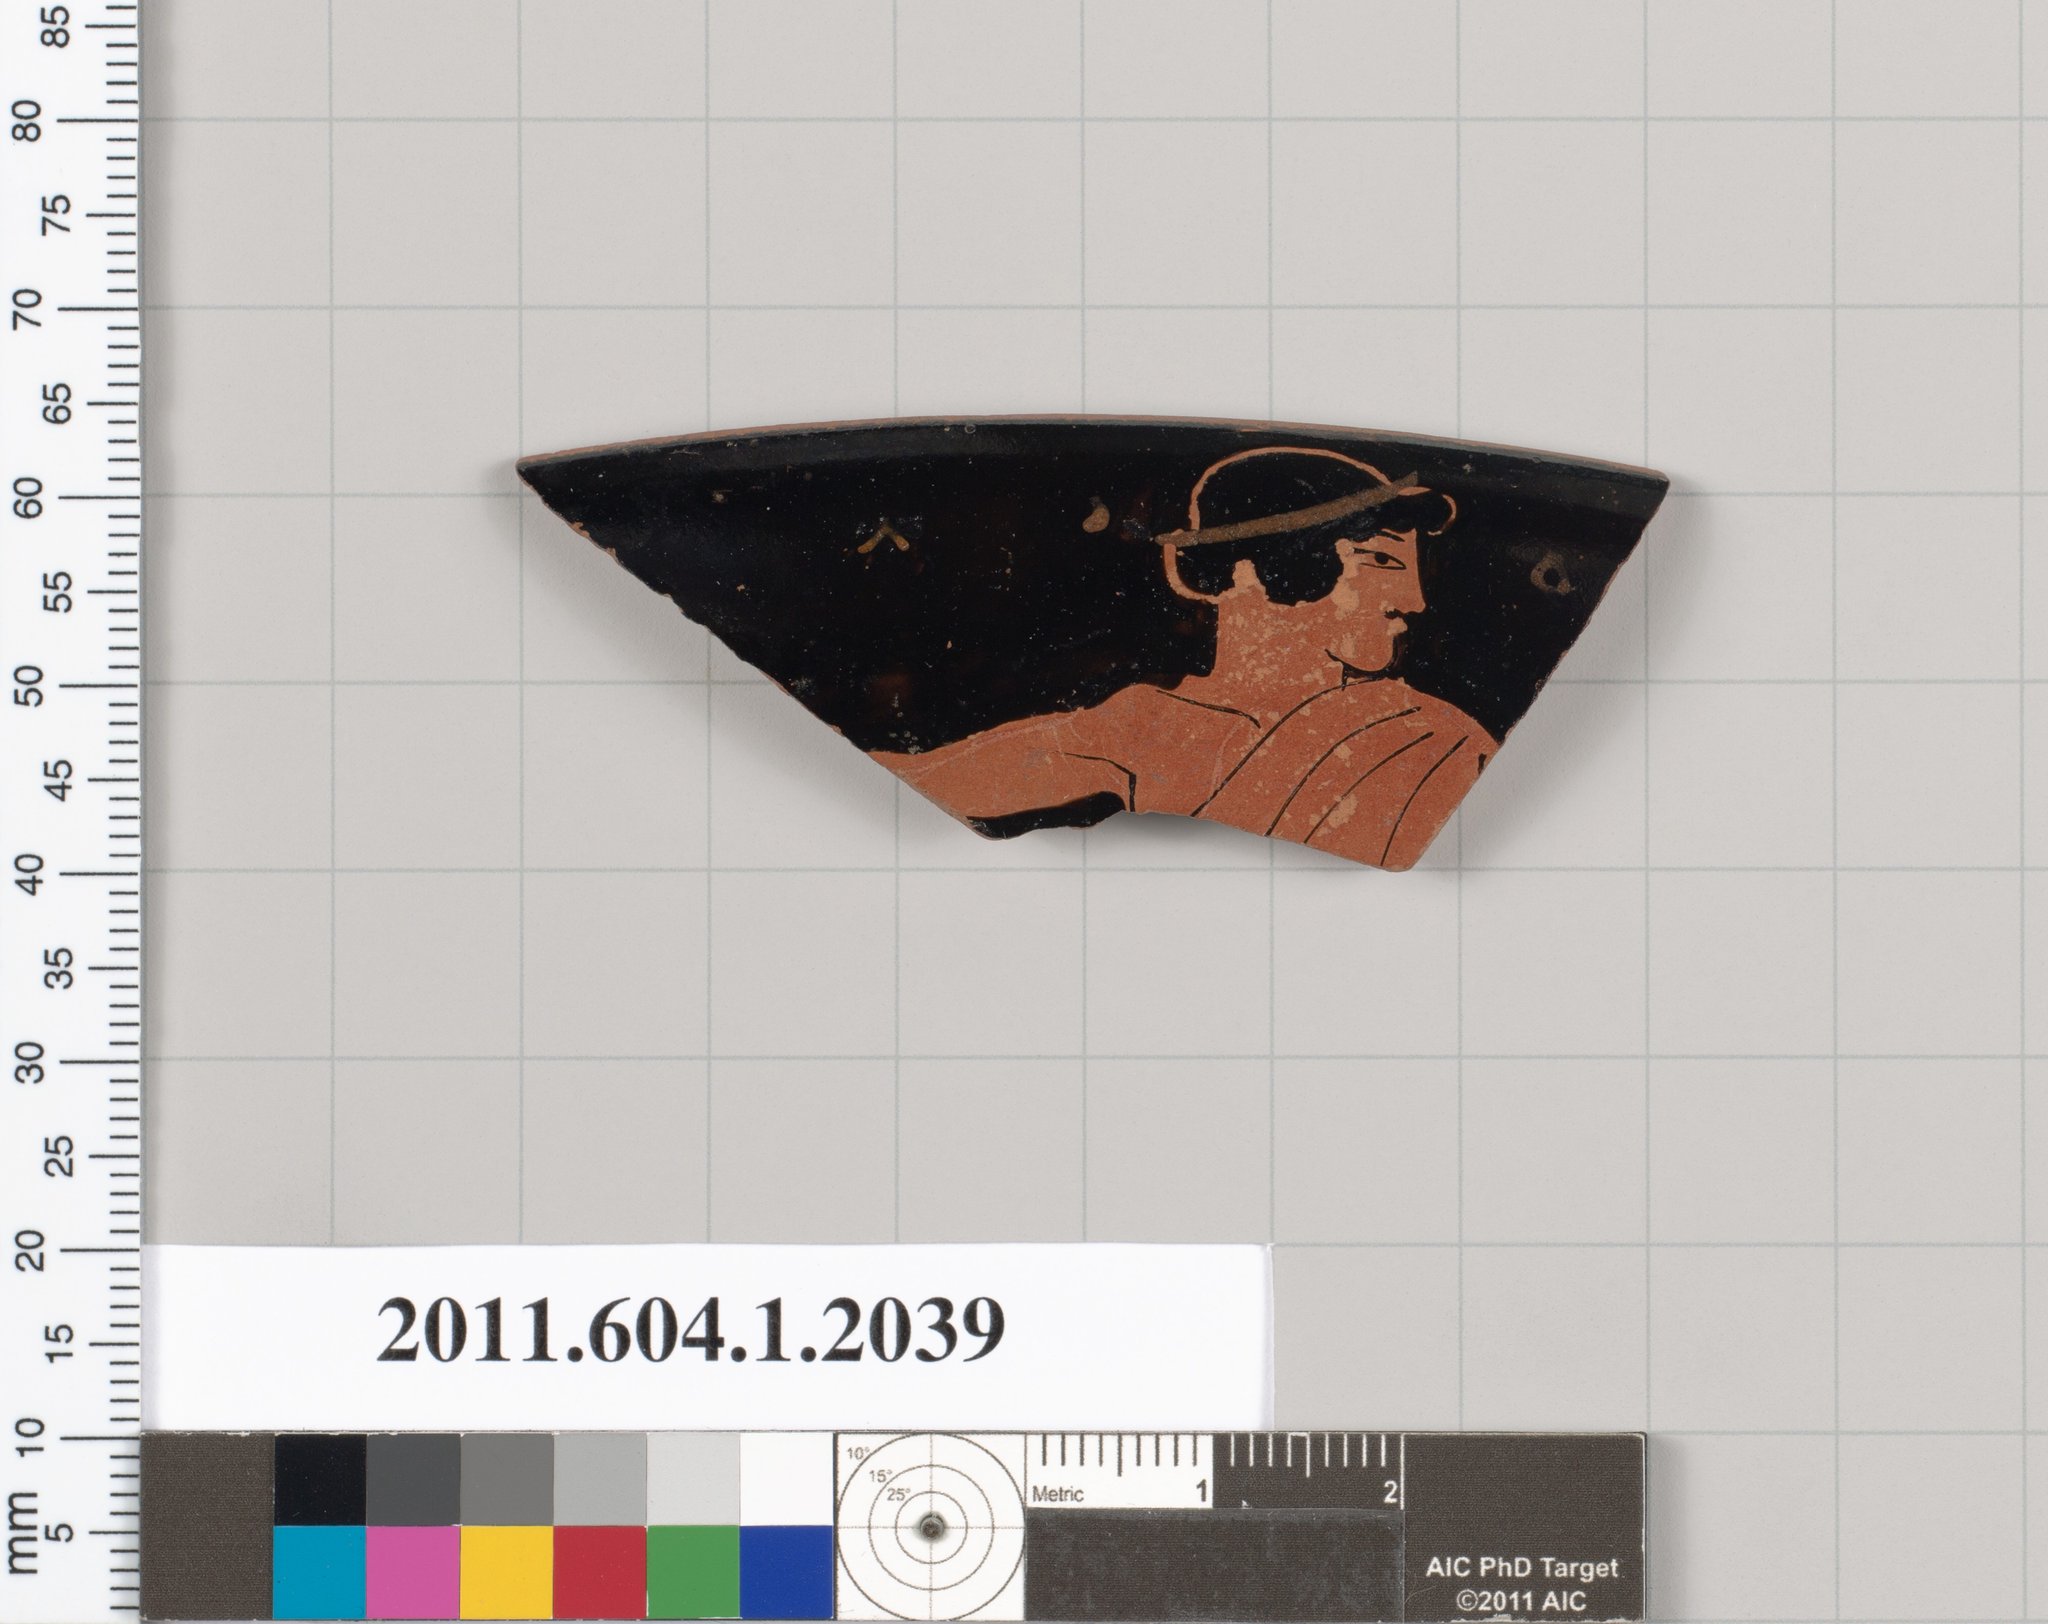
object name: kylix fragment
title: Terracotta rim fragment of a kylix (drinking cup)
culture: greek, attic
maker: painter of louvre g 265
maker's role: artist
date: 475-451 BCE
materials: terracotta